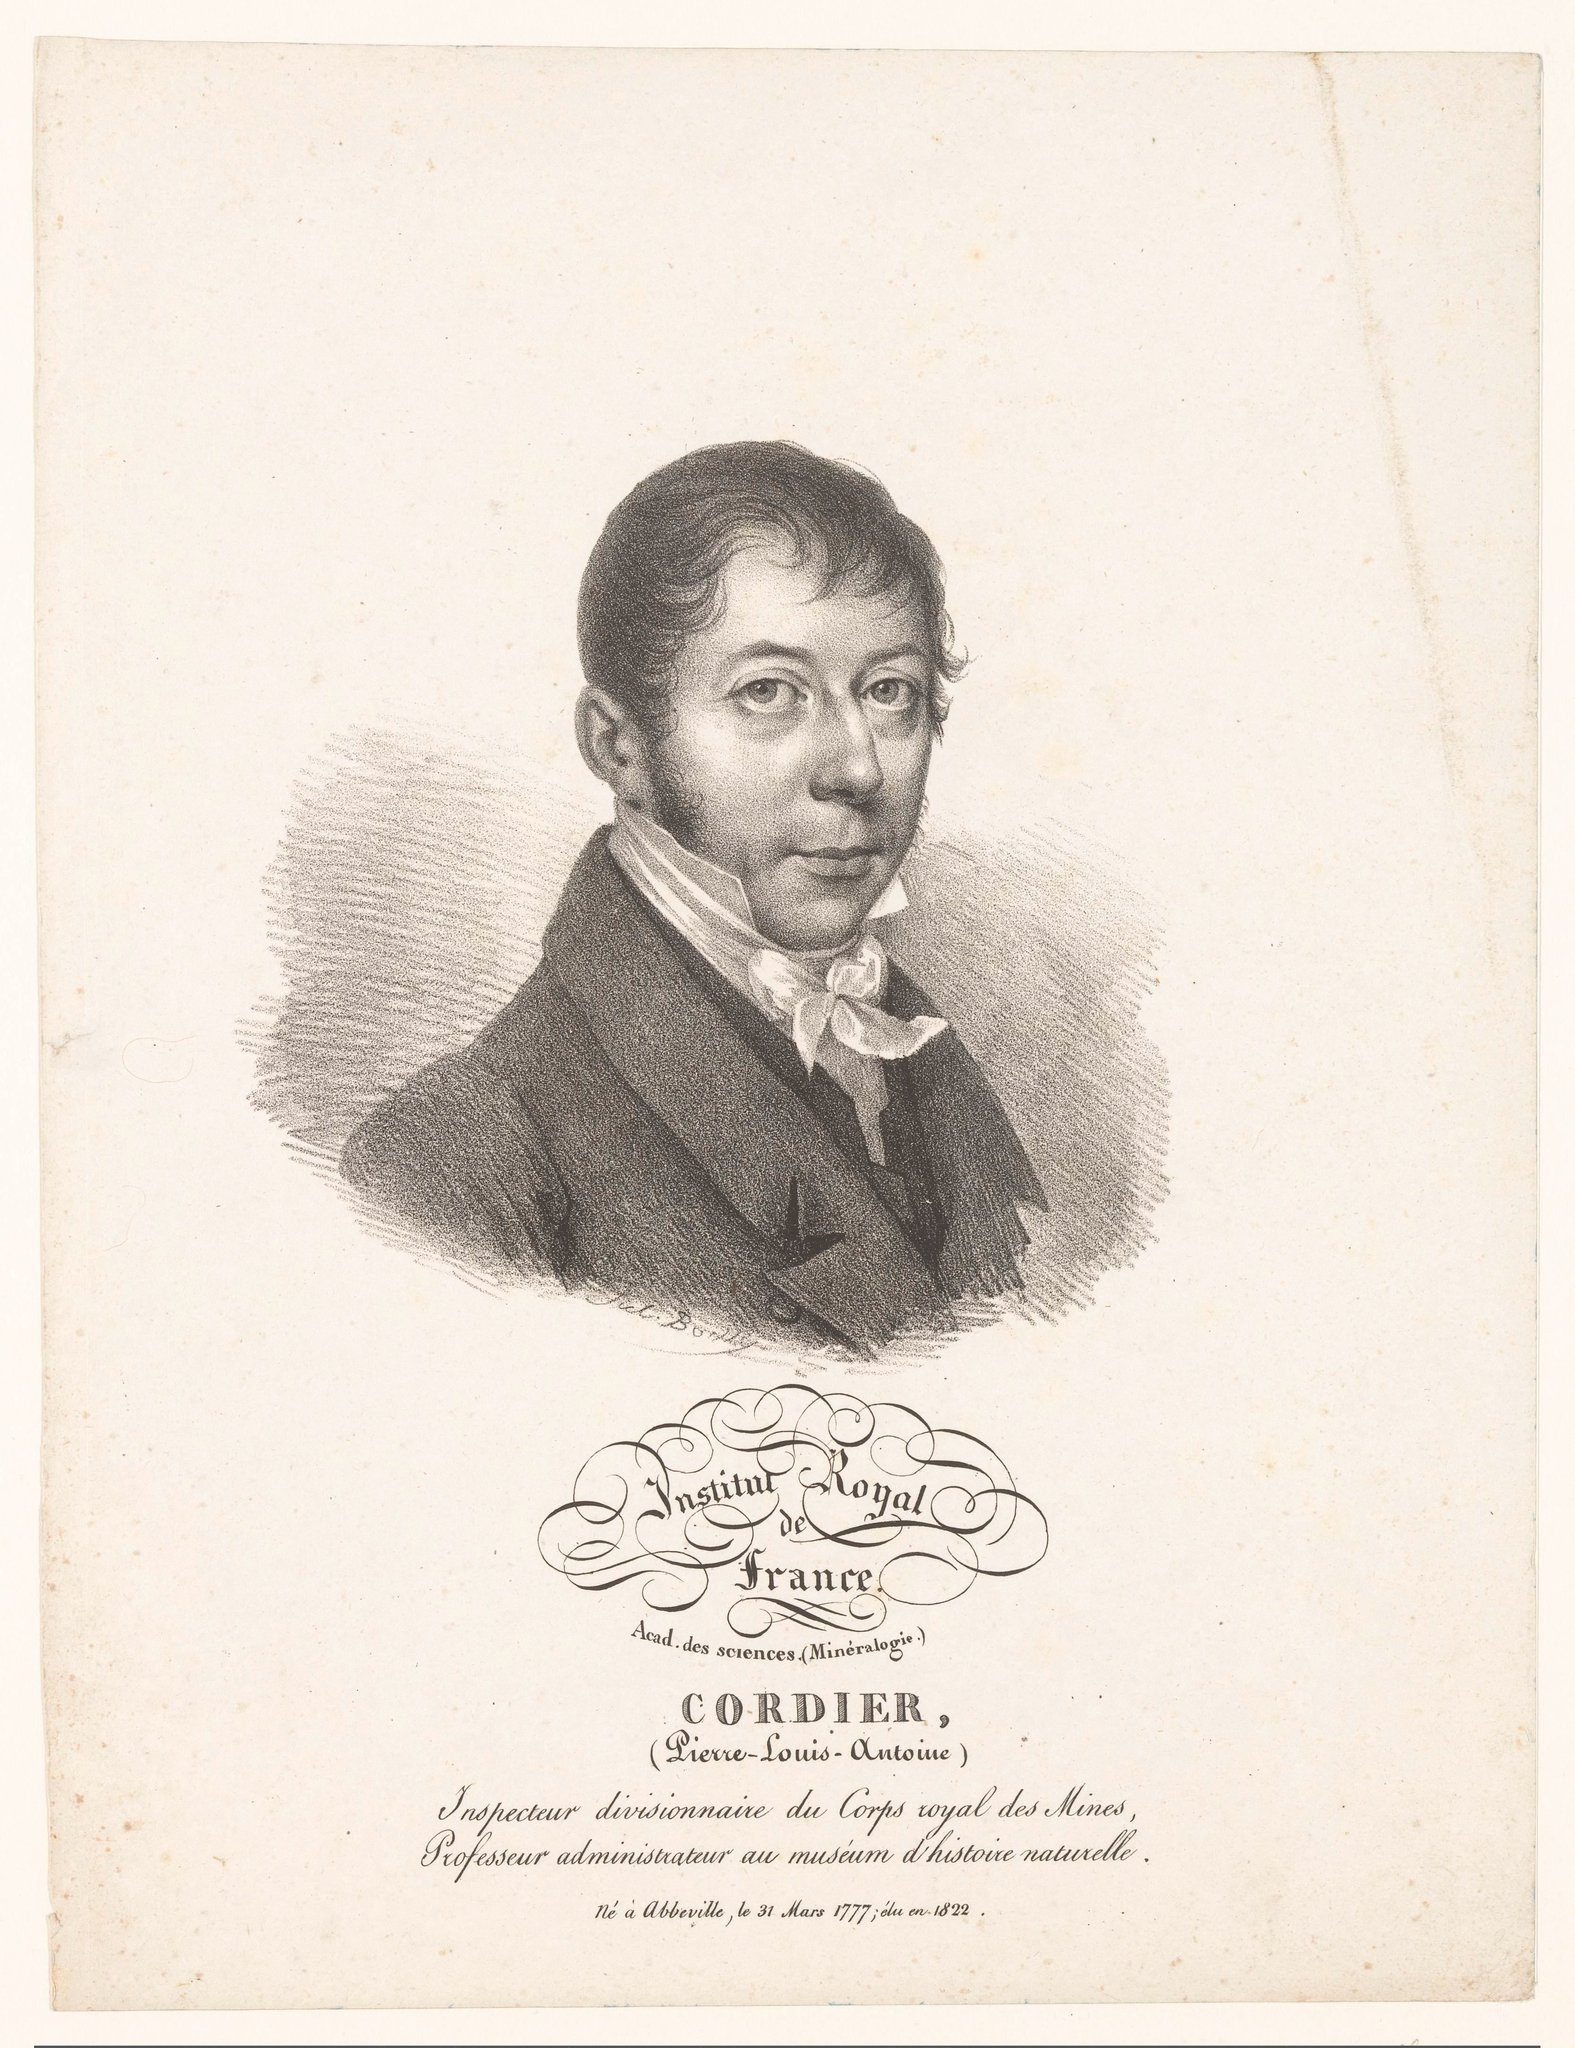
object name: print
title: Cordier, Pierre-Louis-Antoine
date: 1822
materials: paper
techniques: lithograph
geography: paris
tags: paris, historical persons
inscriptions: collector's mark: Lugt 2228a